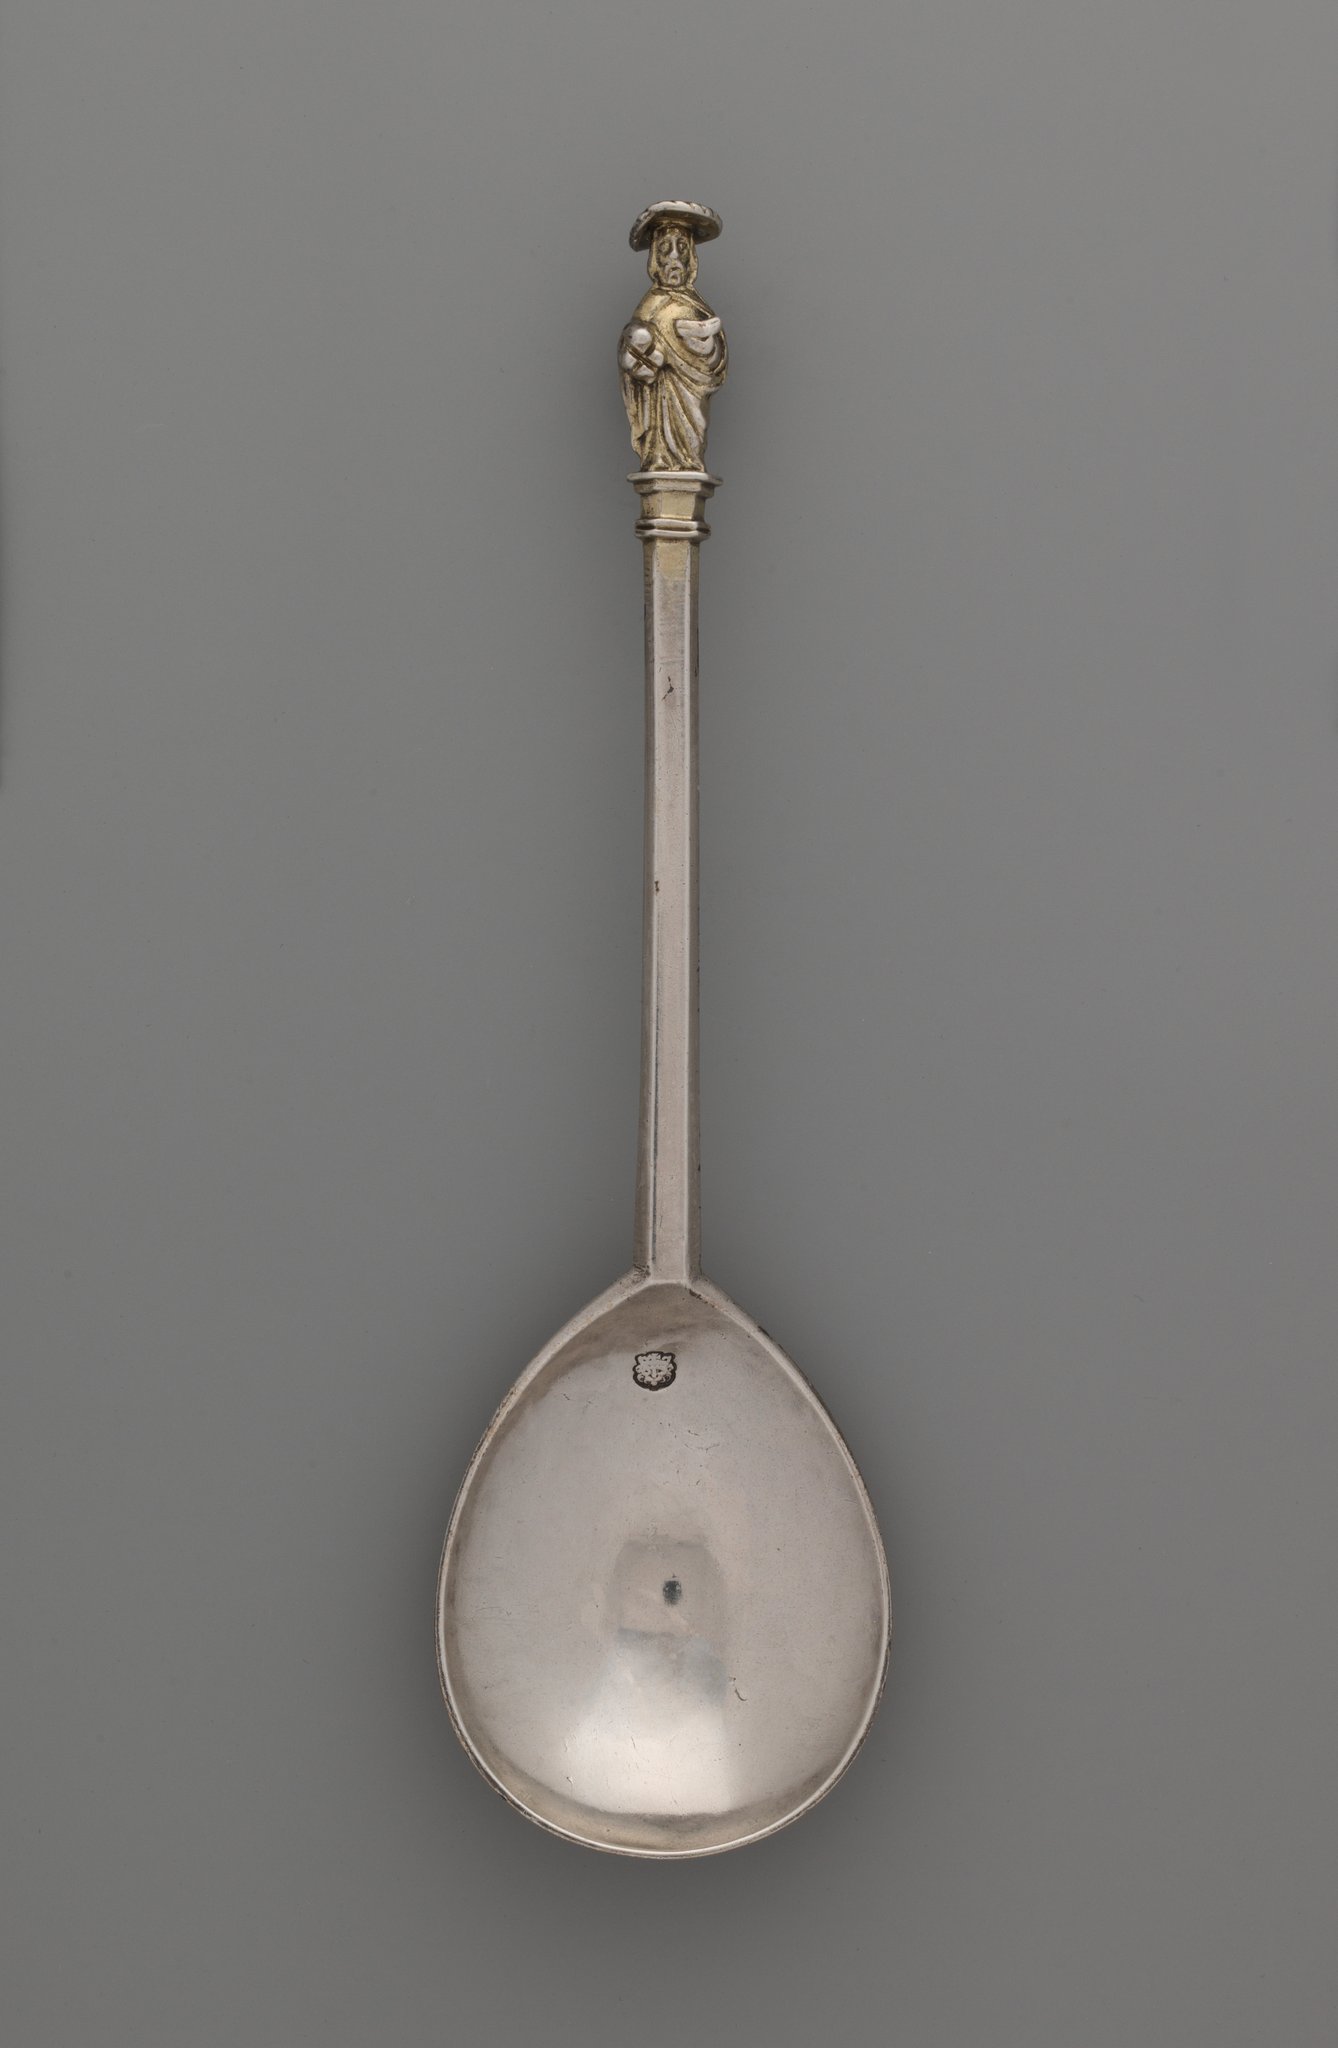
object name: apostle spoon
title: Apostle spoon: St. Matthew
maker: william cawdell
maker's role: maker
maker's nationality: british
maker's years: 1560-1625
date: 1592-1593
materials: silver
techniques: gilding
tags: saints